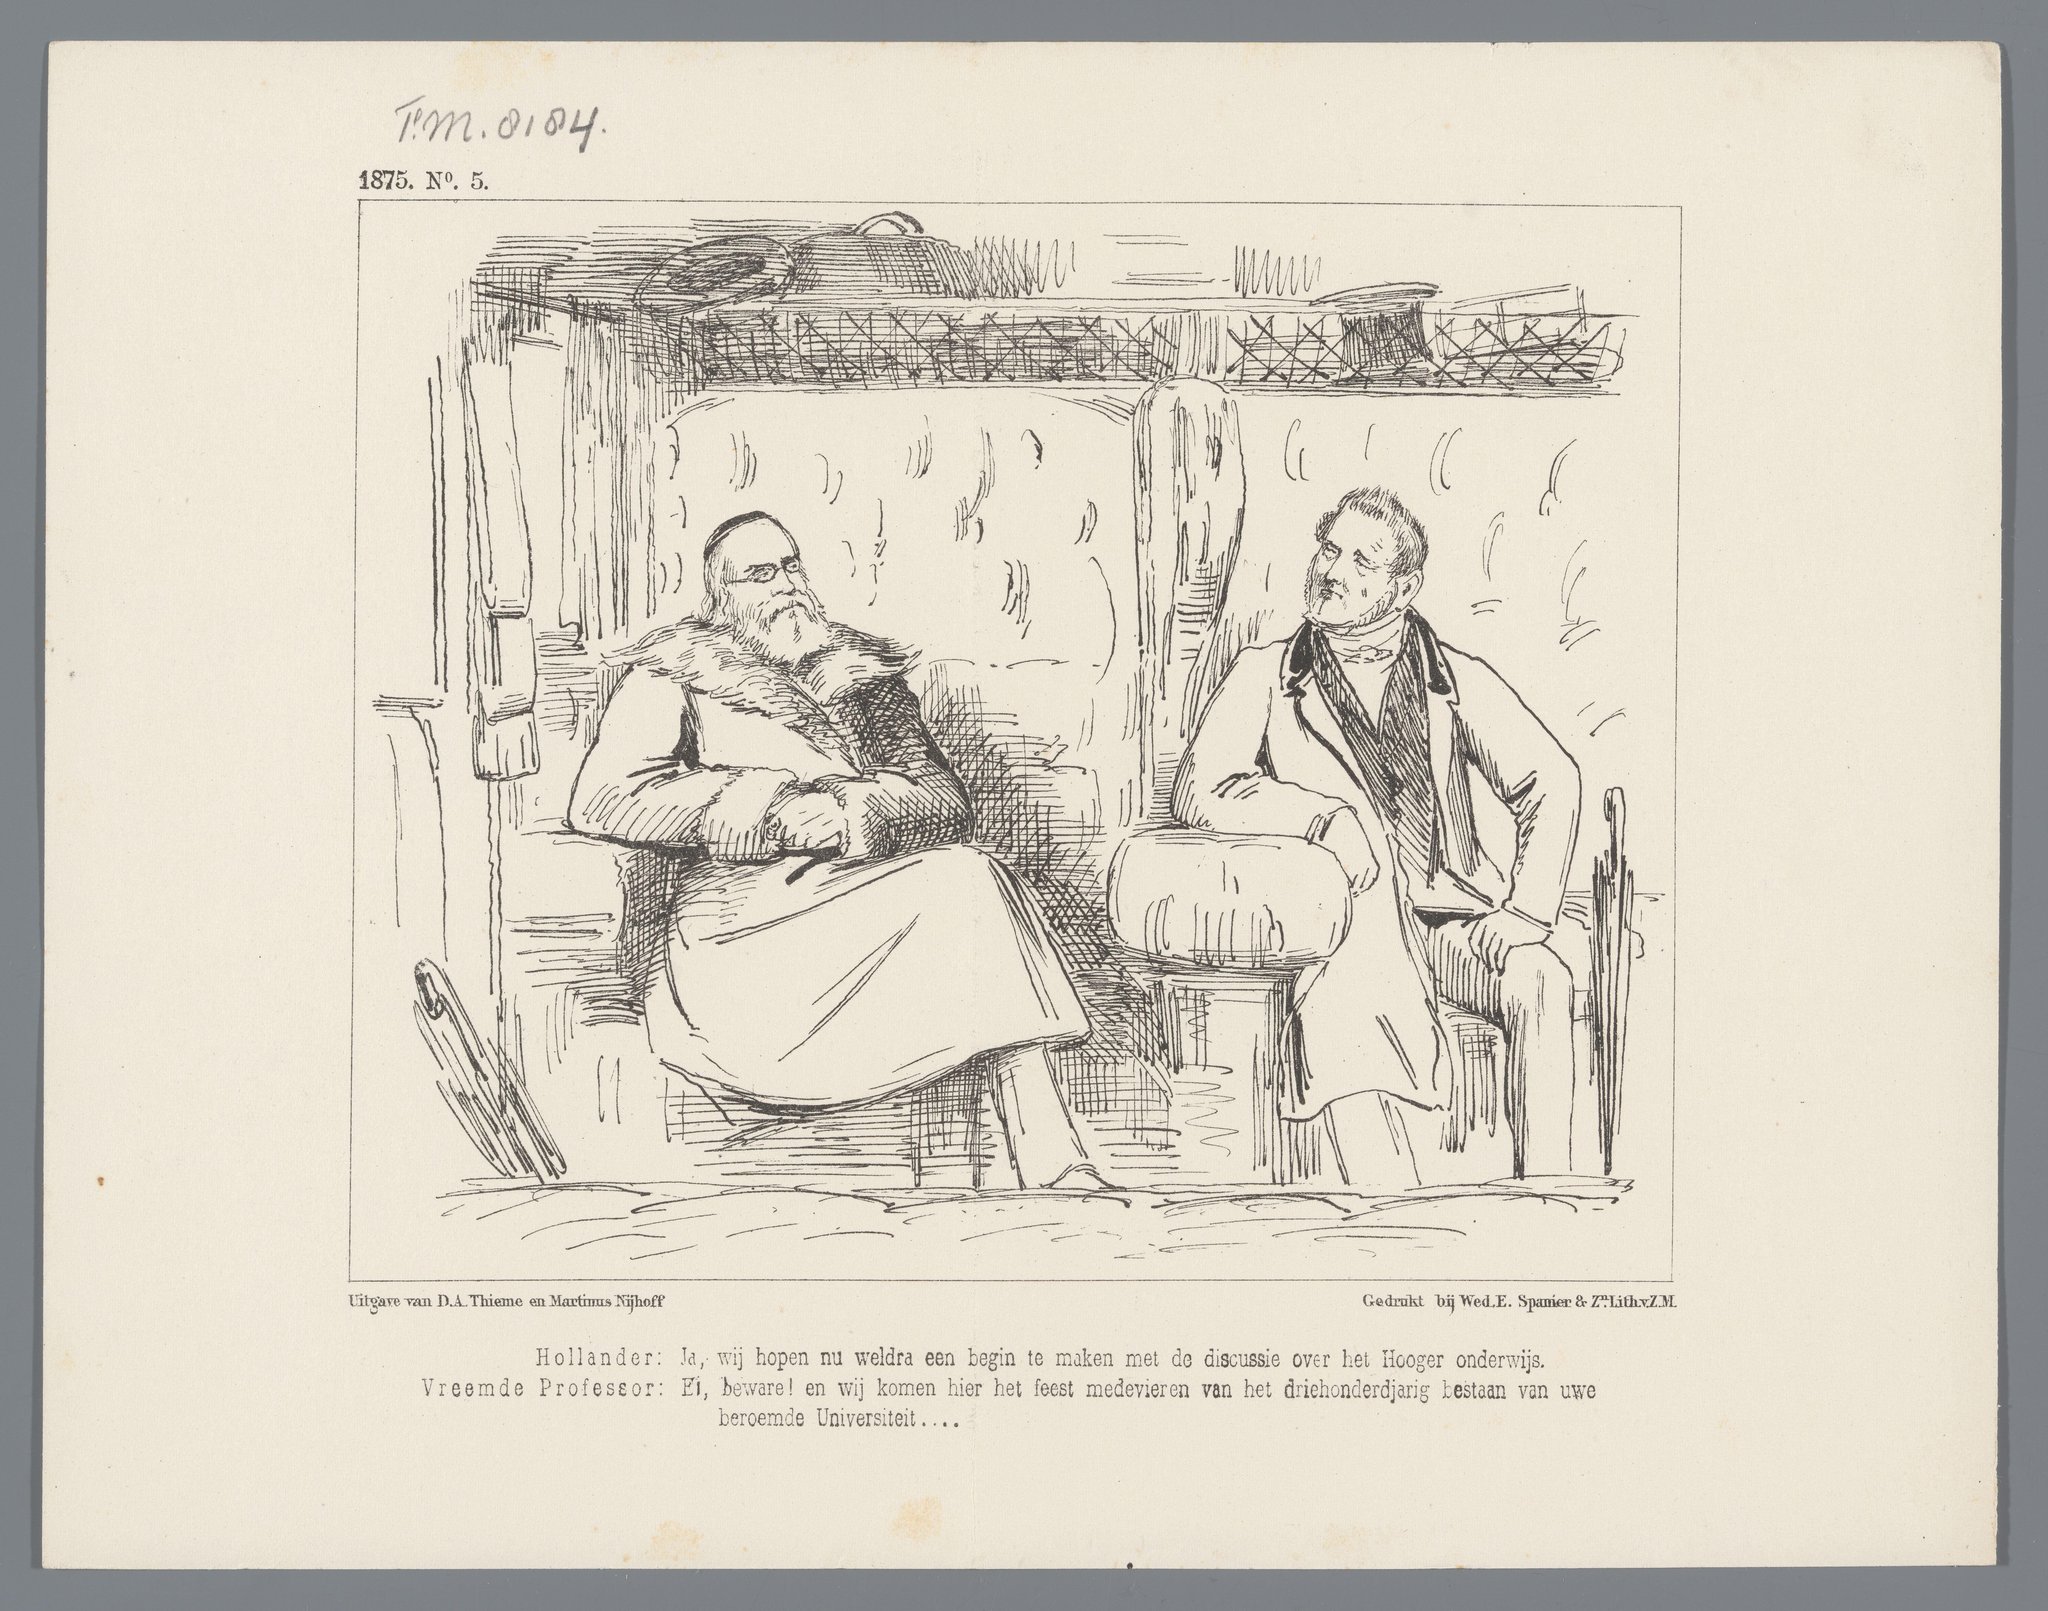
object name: cartoon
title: Spotprent op de traagheid waarmee de wet op het Hoger Onderwijs vordert, 1875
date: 1875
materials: paper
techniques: lithograph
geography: netherlands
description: Spotprent op de traagheid waarmee de totstandkoming van de wet op het Hoger Onderwijs vordert, 1875. Plaat verschenen bij het weekblad De Nederlandsche Spectator, nr. 5, 1875.